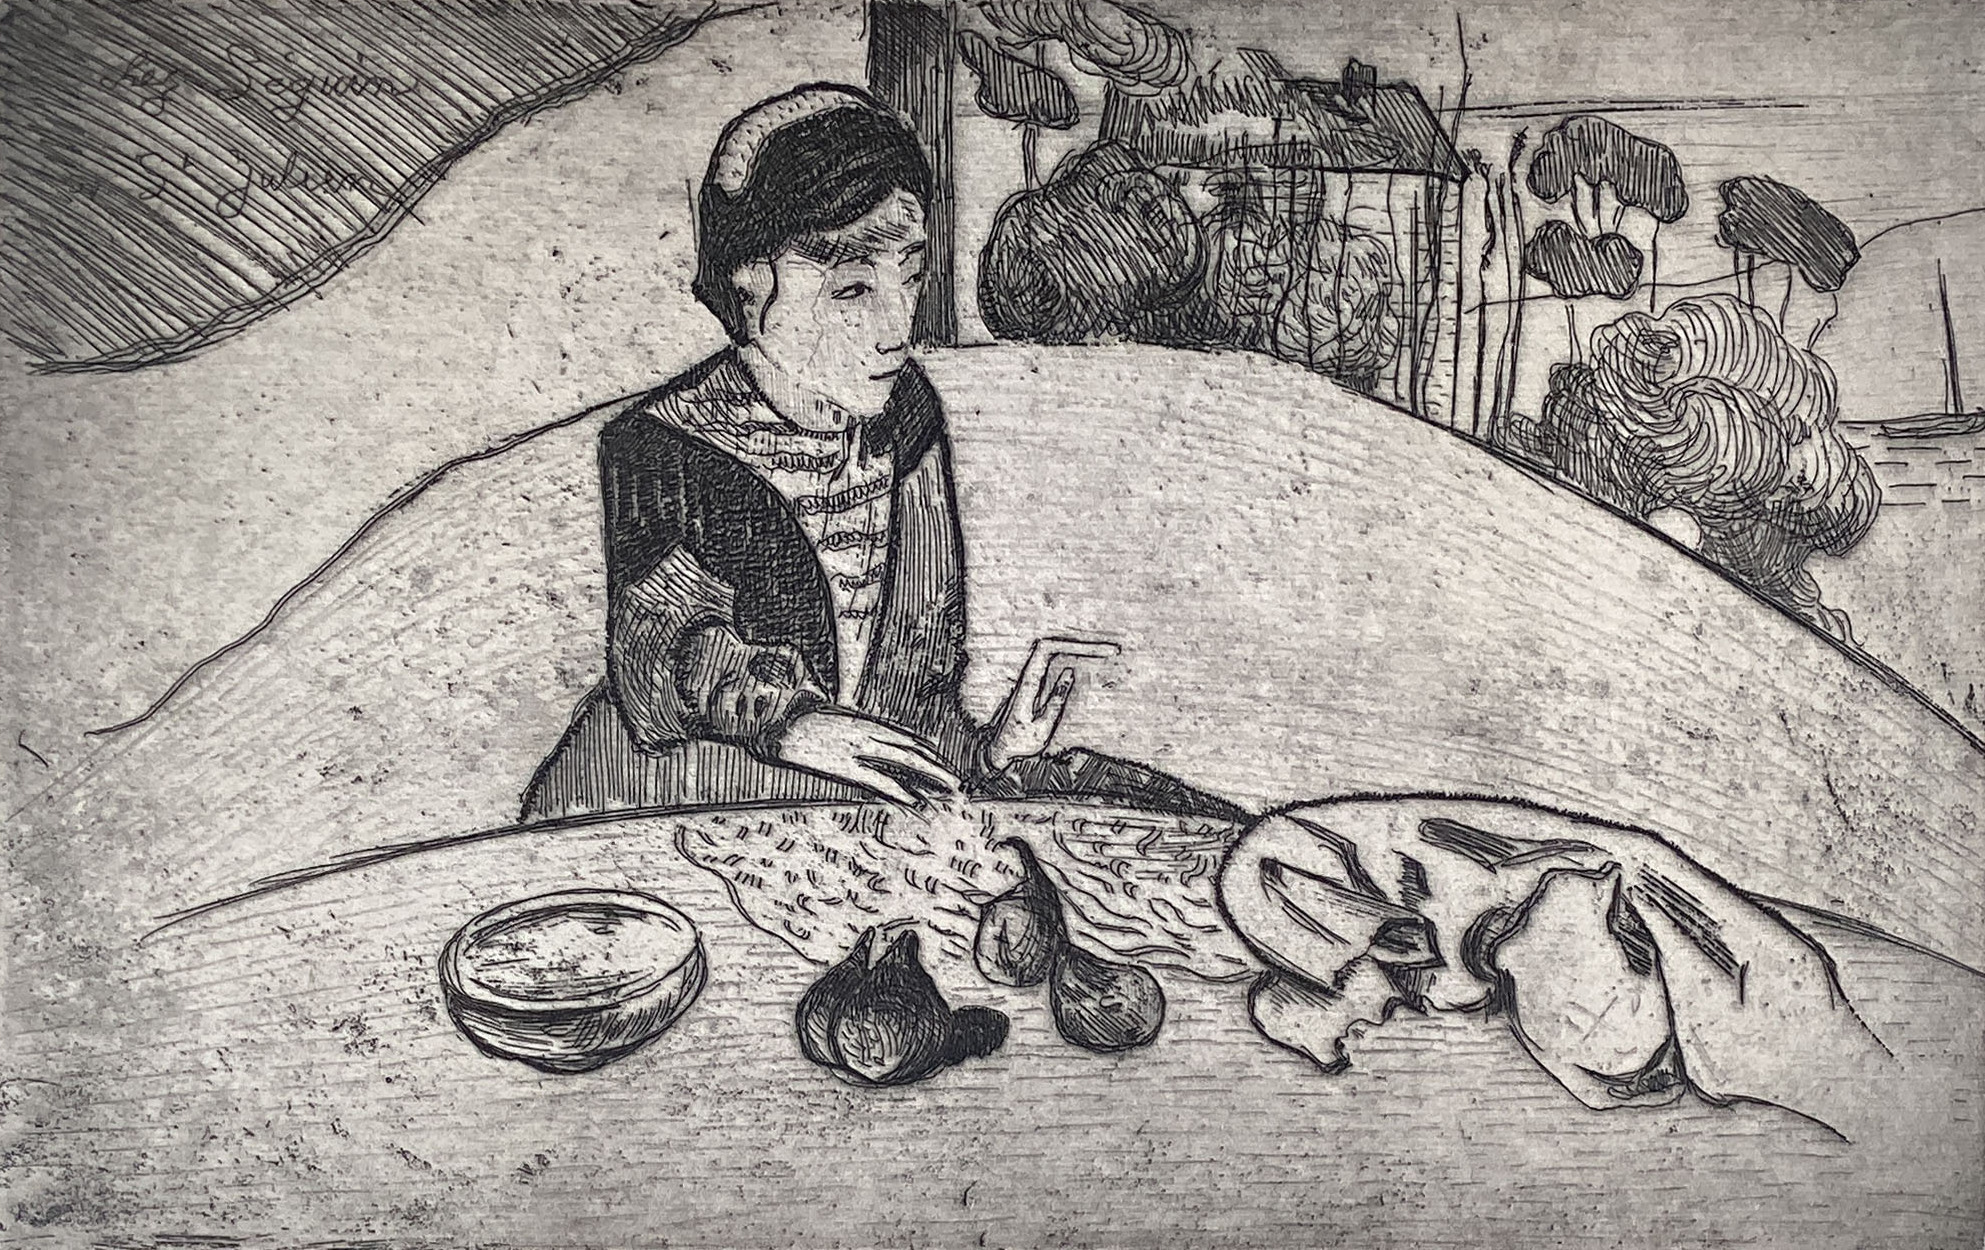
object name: print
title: Woman with Figs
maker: paul gauguin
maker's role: artist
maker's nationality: french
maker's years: 1848-1903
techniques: etching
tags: fruit,women